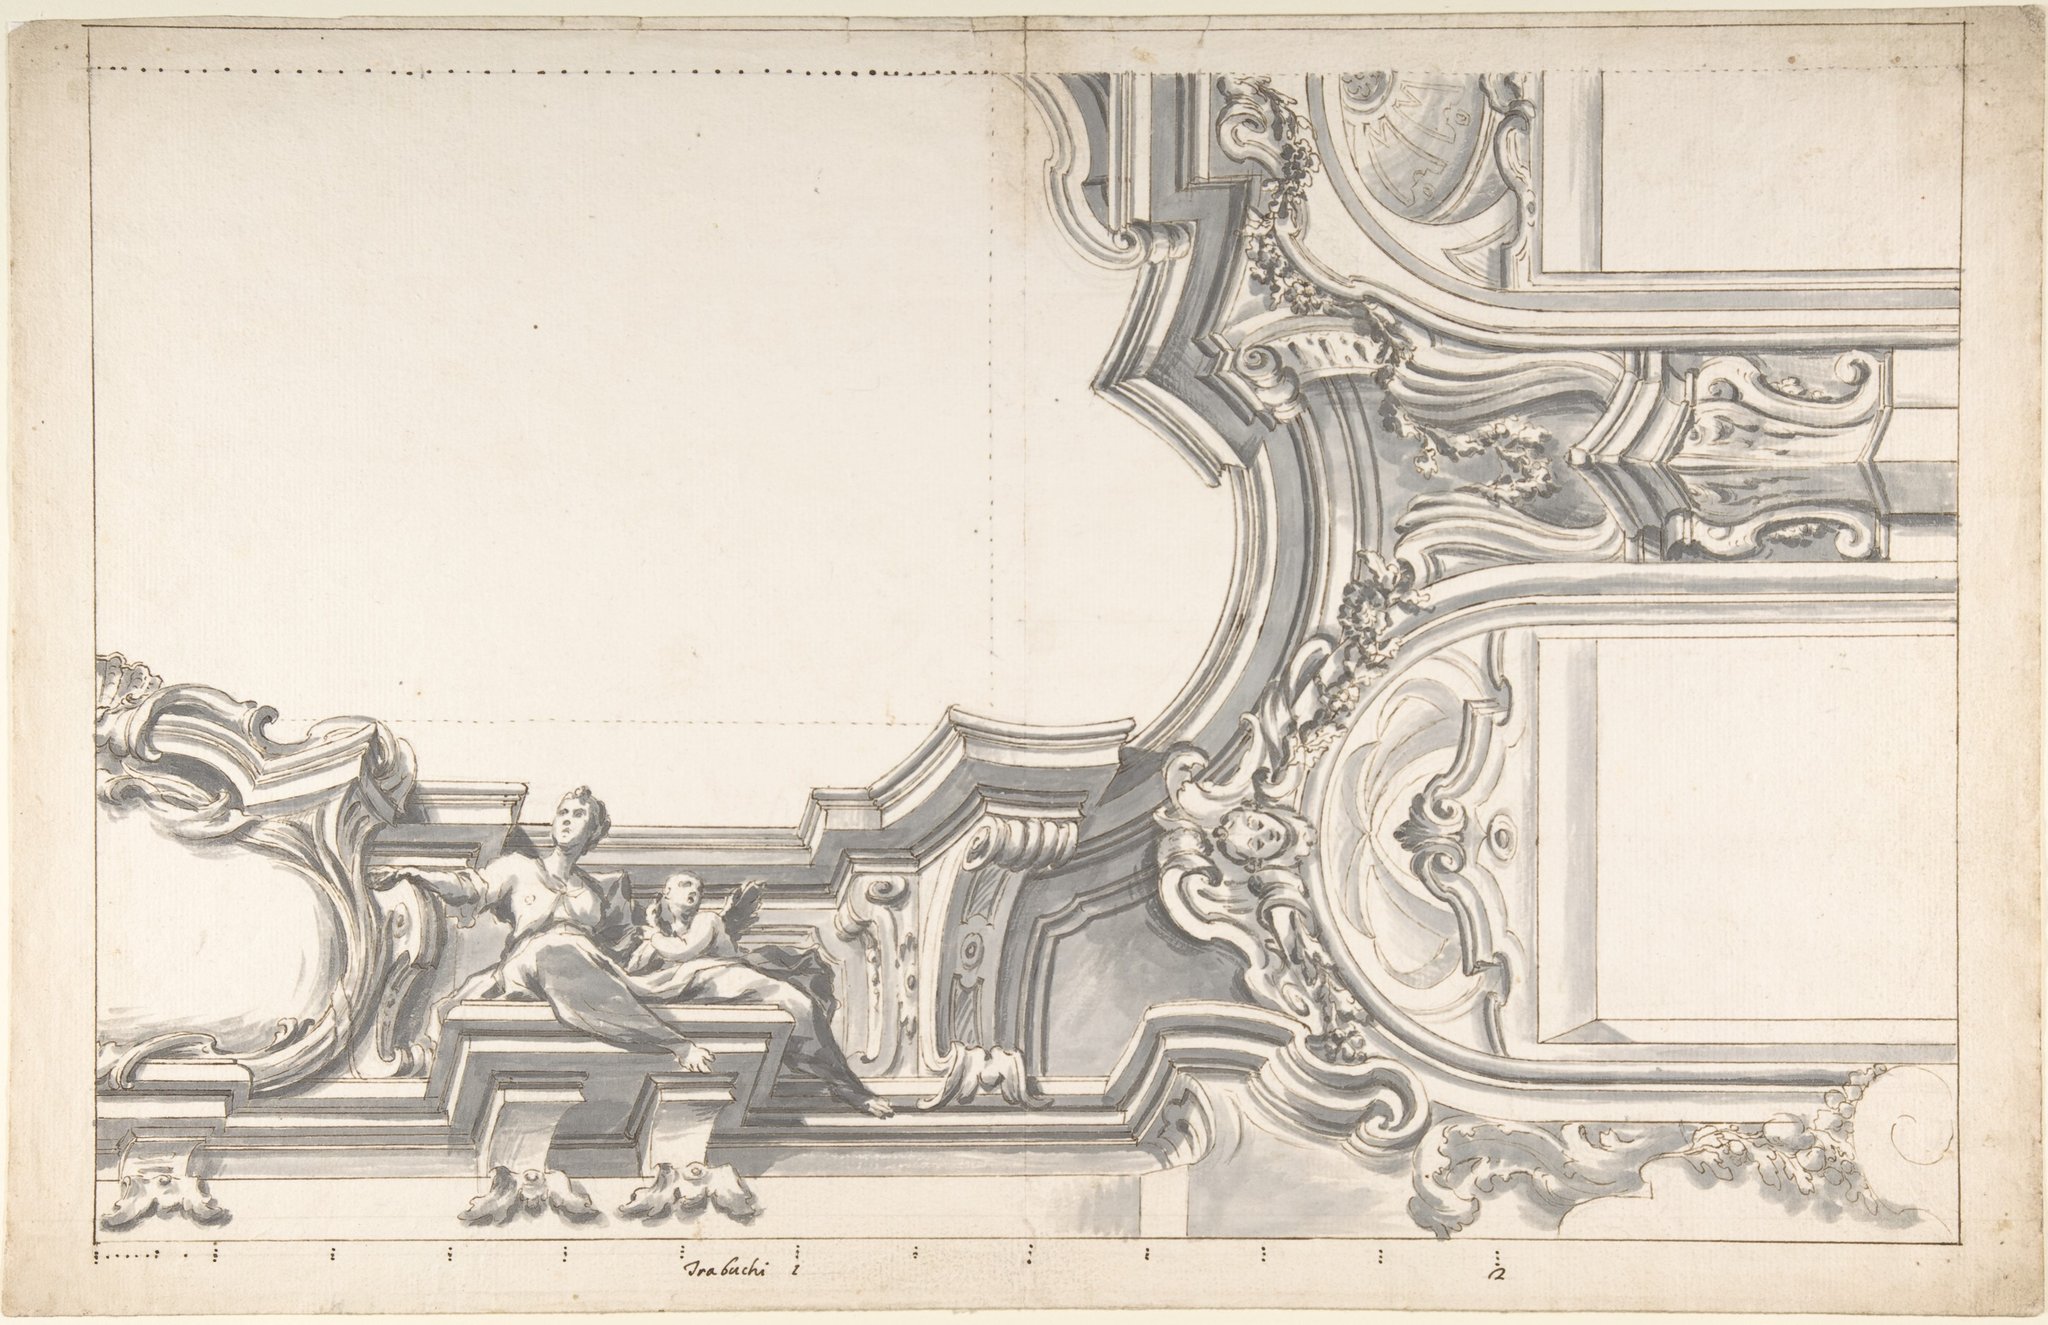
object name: drawing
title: Design for an Elaborate Cornice with a Cartouche and Figures Supporting a Ceiling, with Two Arched Openings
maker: anonymous, italian, piedmontese, 18th century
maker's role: artist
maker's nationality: italian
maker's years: 1700-1800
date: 1700-1780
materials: graphite, ink, drawing material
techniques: brush, incising, pen, wash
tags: architecture,ceilings